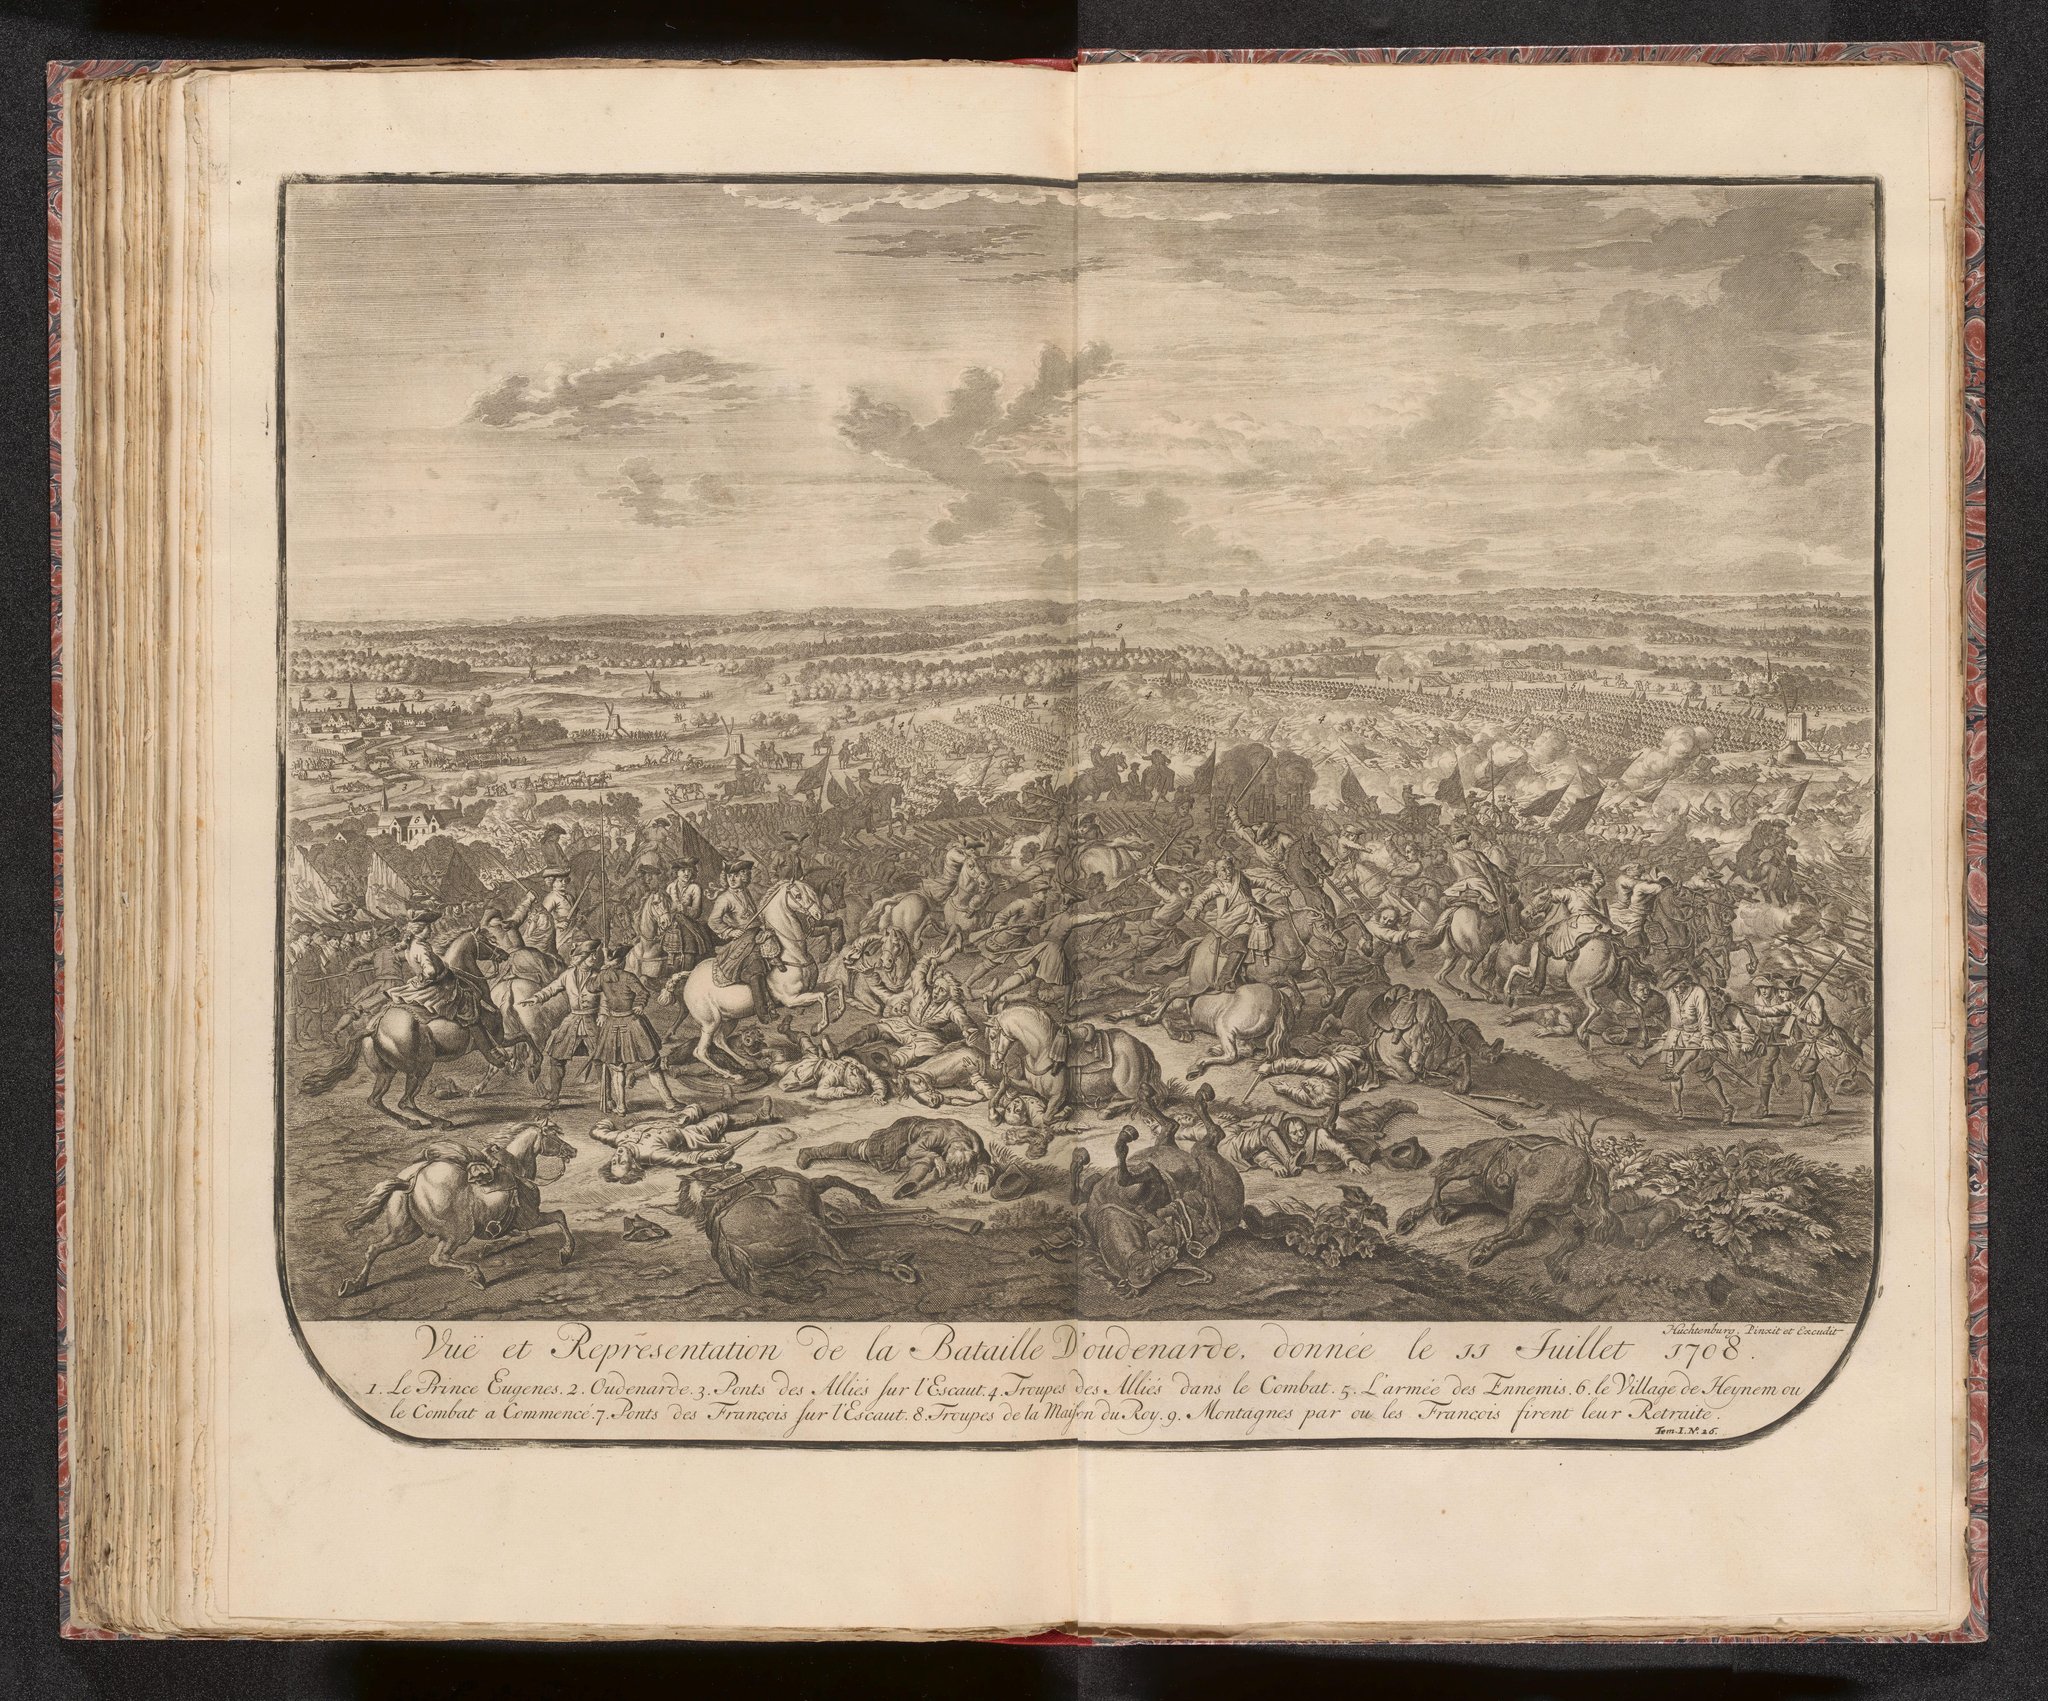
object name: print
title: Slag bij Oudenaarde, 1708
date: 1727-1729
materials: paper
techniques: engraving, etching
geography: the hague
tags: paris, vienna, eugenius van savoye, battle (+ land forces)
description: De slag bij Oudenaarde tussen de Geallieerden onder de prins van Savoye en de hertog van Marlborough en de Fransen, 11 juli 1708. Links de prins te paard. Genummerd rechtsonder: Tom. I. No. 26. Illustratie in het eerste deel van: Jean du Mont, Oorlogskundige beschryving van de veldslagen en belegeringen, der drie ... wydvermaarde krygsoversten... den Prins Eugenius van Savoye, den ... Hertog van Marlborough, en den Prins van Oranje en Nassau-Vriesland, in de editie van 1729. Dit eerste deel is gewijd aan de daden van Eugenius, prins van Savoye.